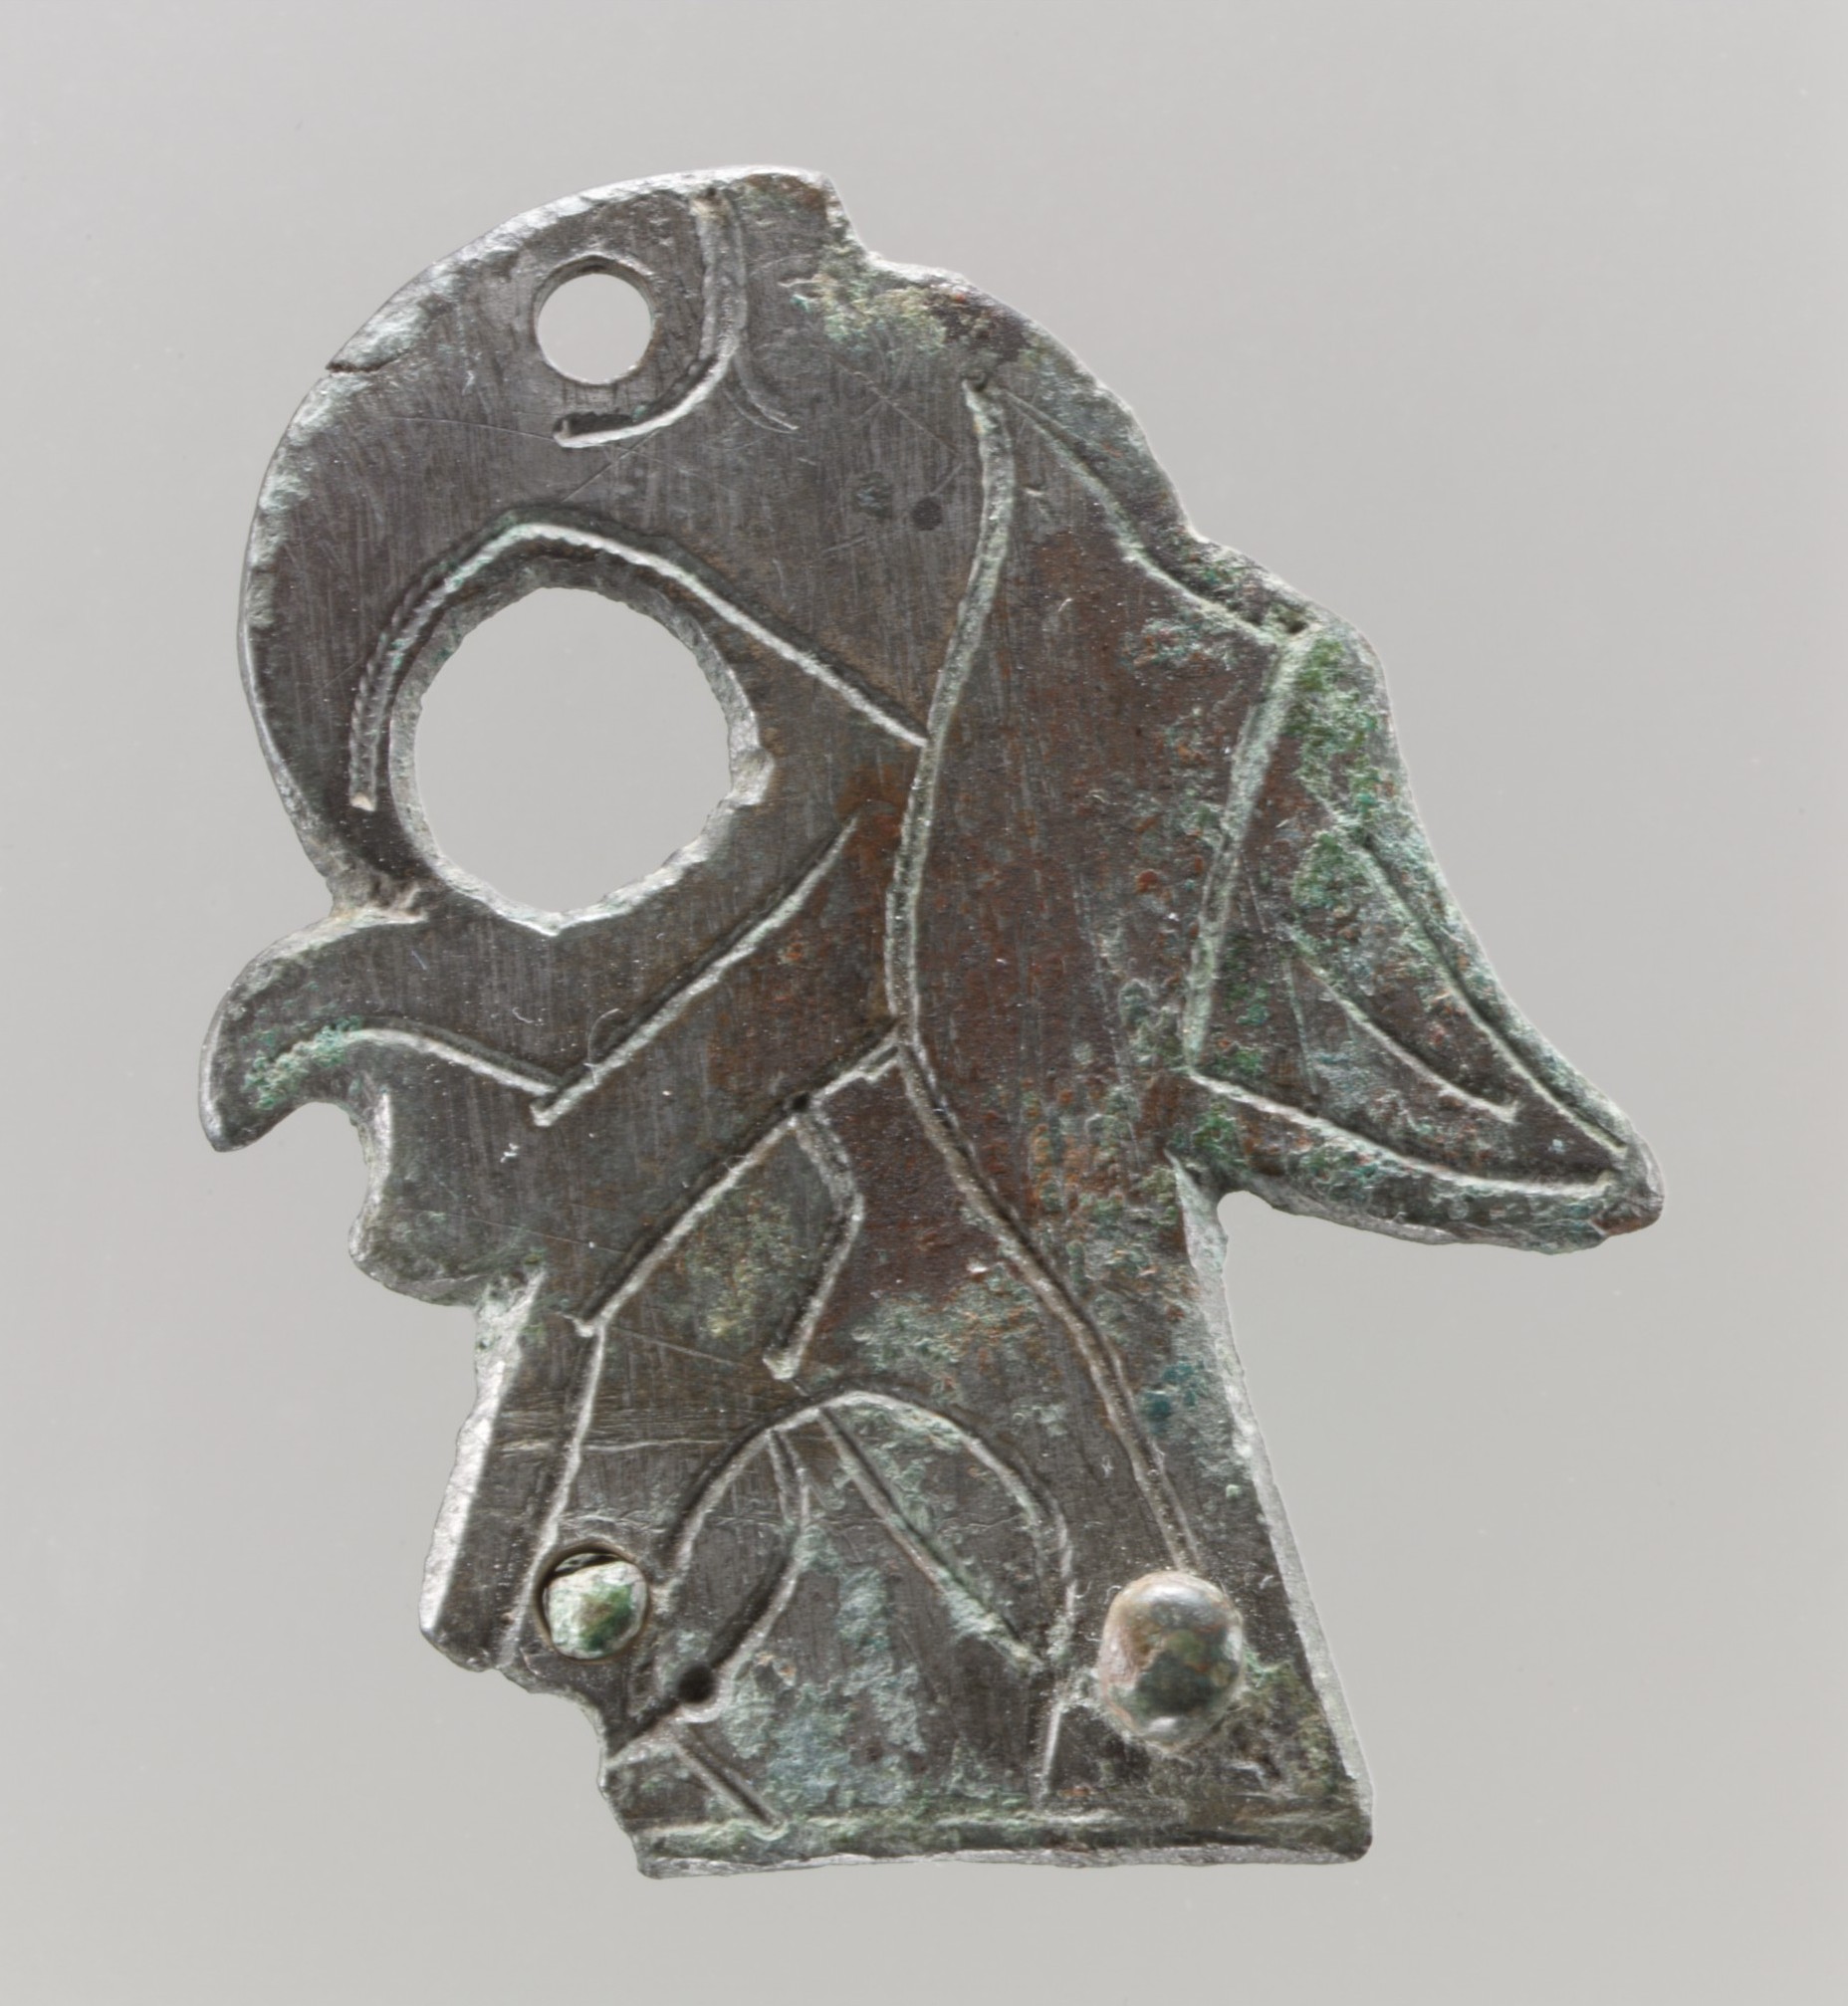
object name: shield mount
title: Shield Mount in the Shape of Bird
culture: frankish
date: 551-600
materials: copper alloy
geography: northern france